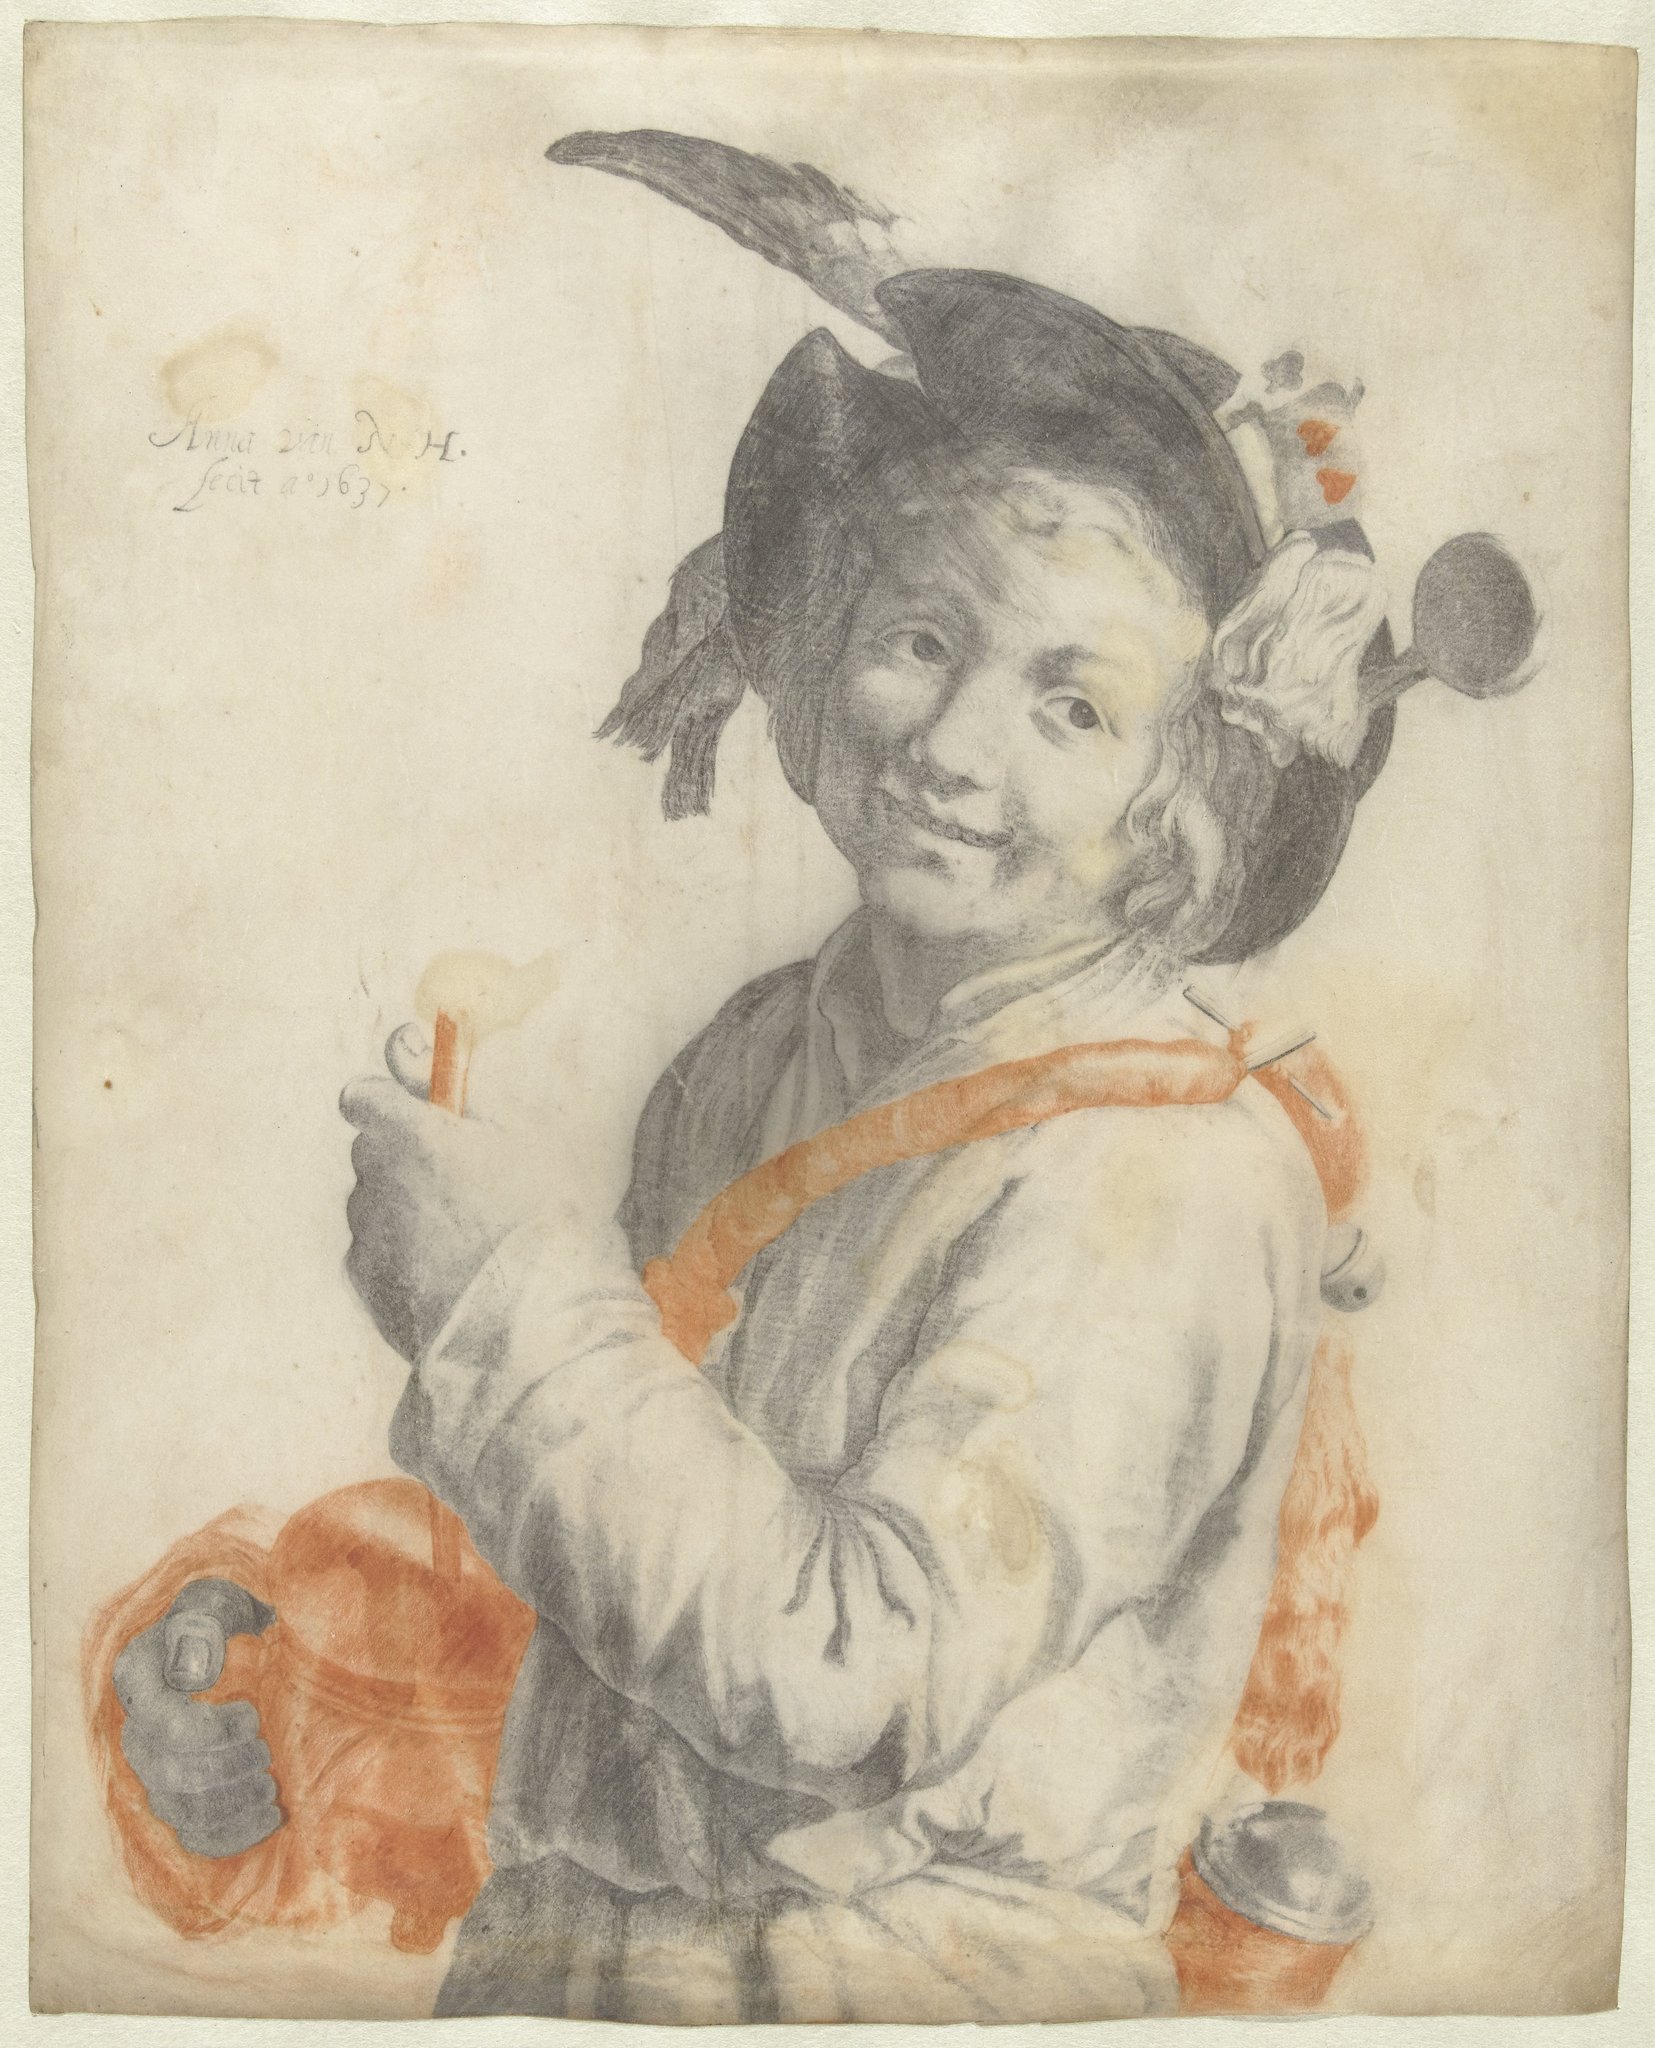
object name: drawing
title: Rommelpotspelende jongen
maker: anna van n.h.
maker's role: draughtsman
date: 1637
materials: chalk, parchment, pencil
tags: improvised musical instruments: rumbling pot, 'music' of children